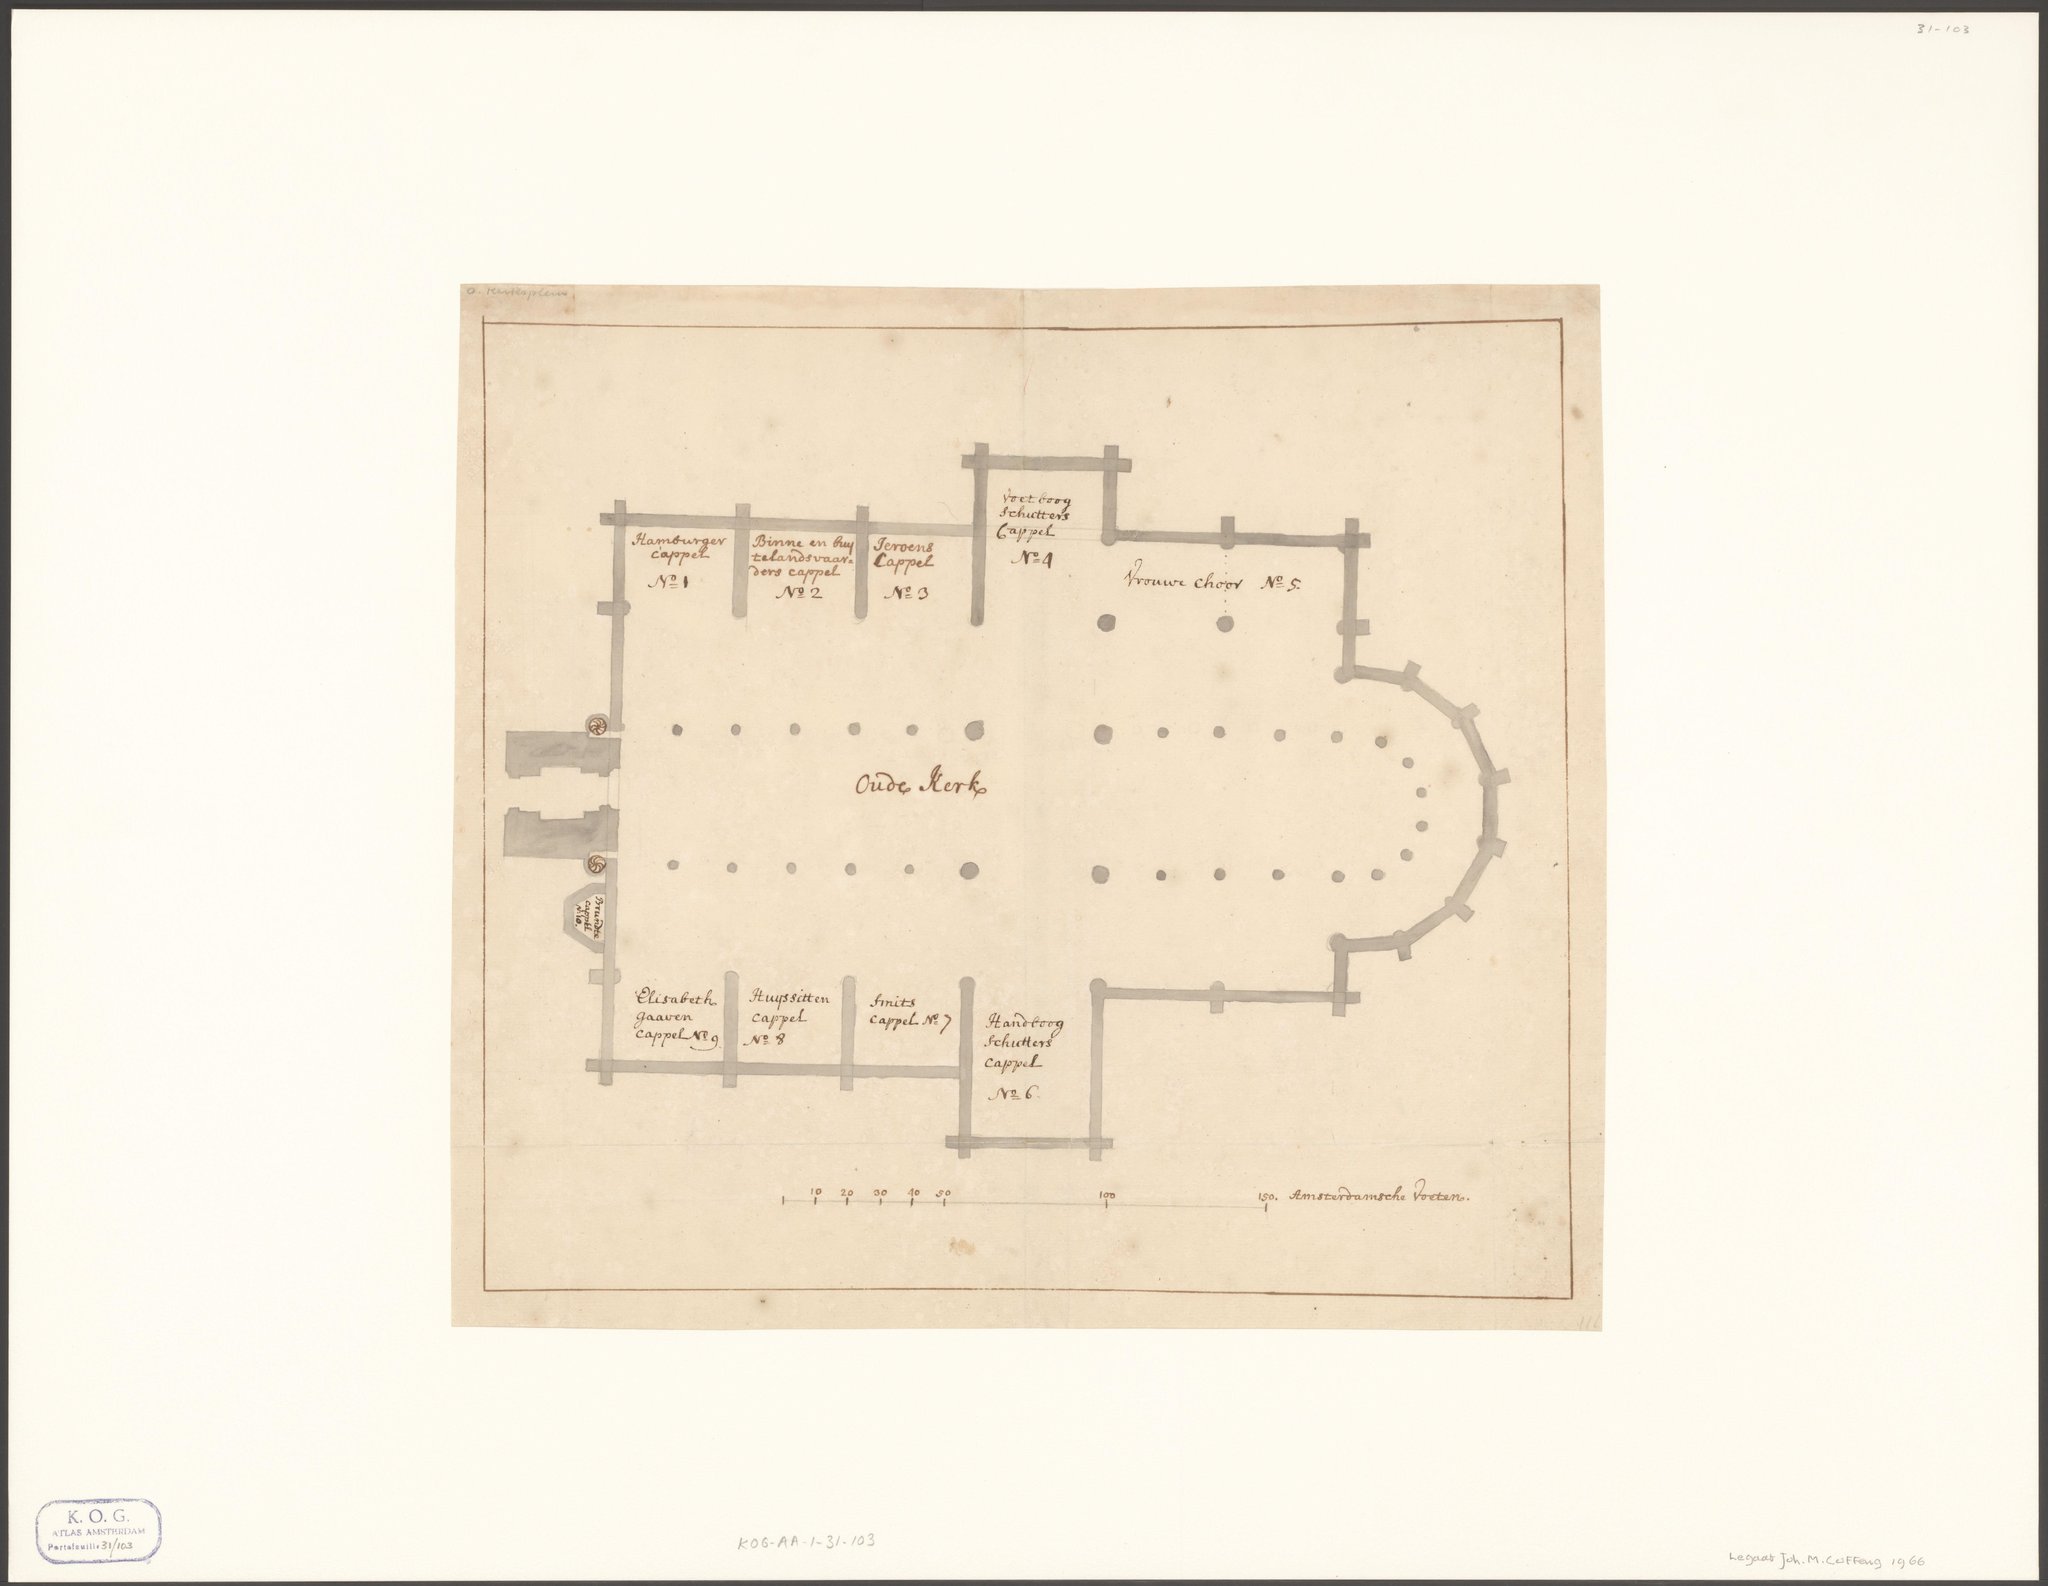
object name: drawing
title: Plattegrond van de Oude Kerk te Amsterdam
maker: Anonymous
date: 1599-1750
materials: ink, paper, pencil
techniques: brush, pen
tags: interior of church, parts of church exterior and annexes, plan ~ architecture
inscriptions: collector's mark: ‘ 31/103 ’ Lugt 1641b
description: Met negen genummerde kapellen en het Vrouwenkoor. Onder een schaalstok: 150 Amsterdamse Voeten. Onderwerpsrubriek binnen de Atlas Amsterdam: Kerkwezen: Hervormde Gemeente: Oude Kerk van binnen.